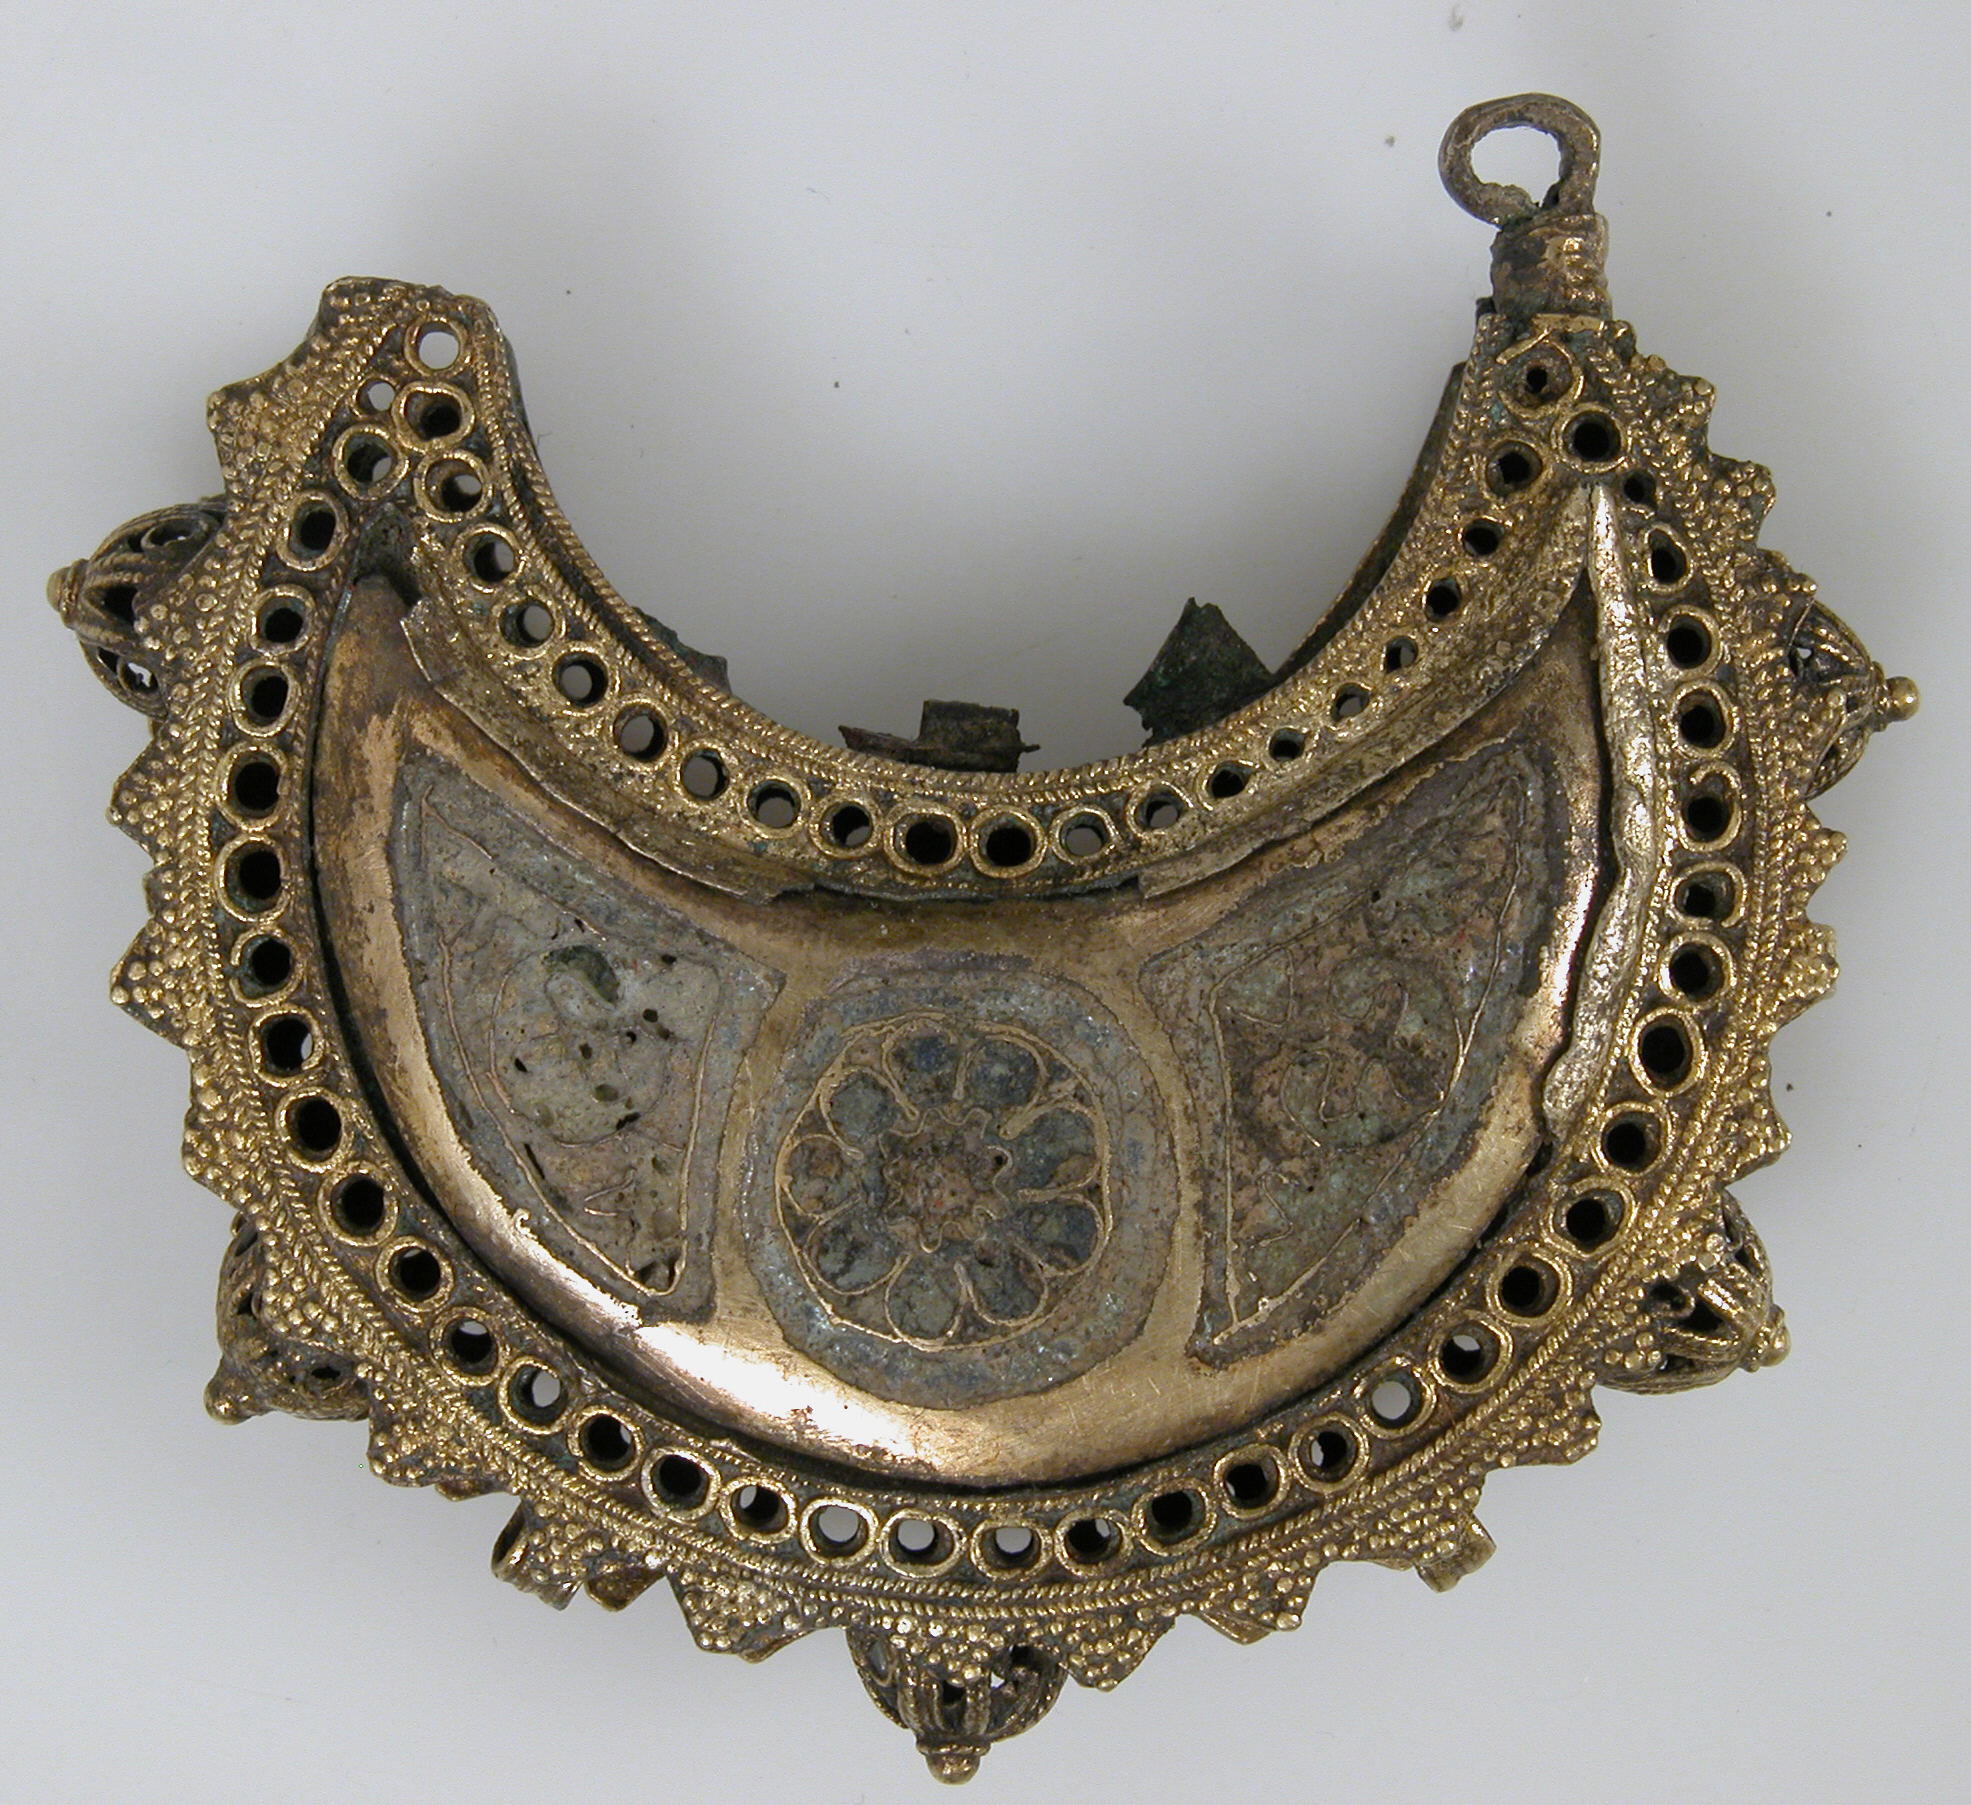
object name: earring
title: One of a Pair of Crescent-Shaped Earrings with Rosettes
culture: byzantine or kyivan rus'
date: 1101-1200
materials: enamel, gold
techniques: enamel